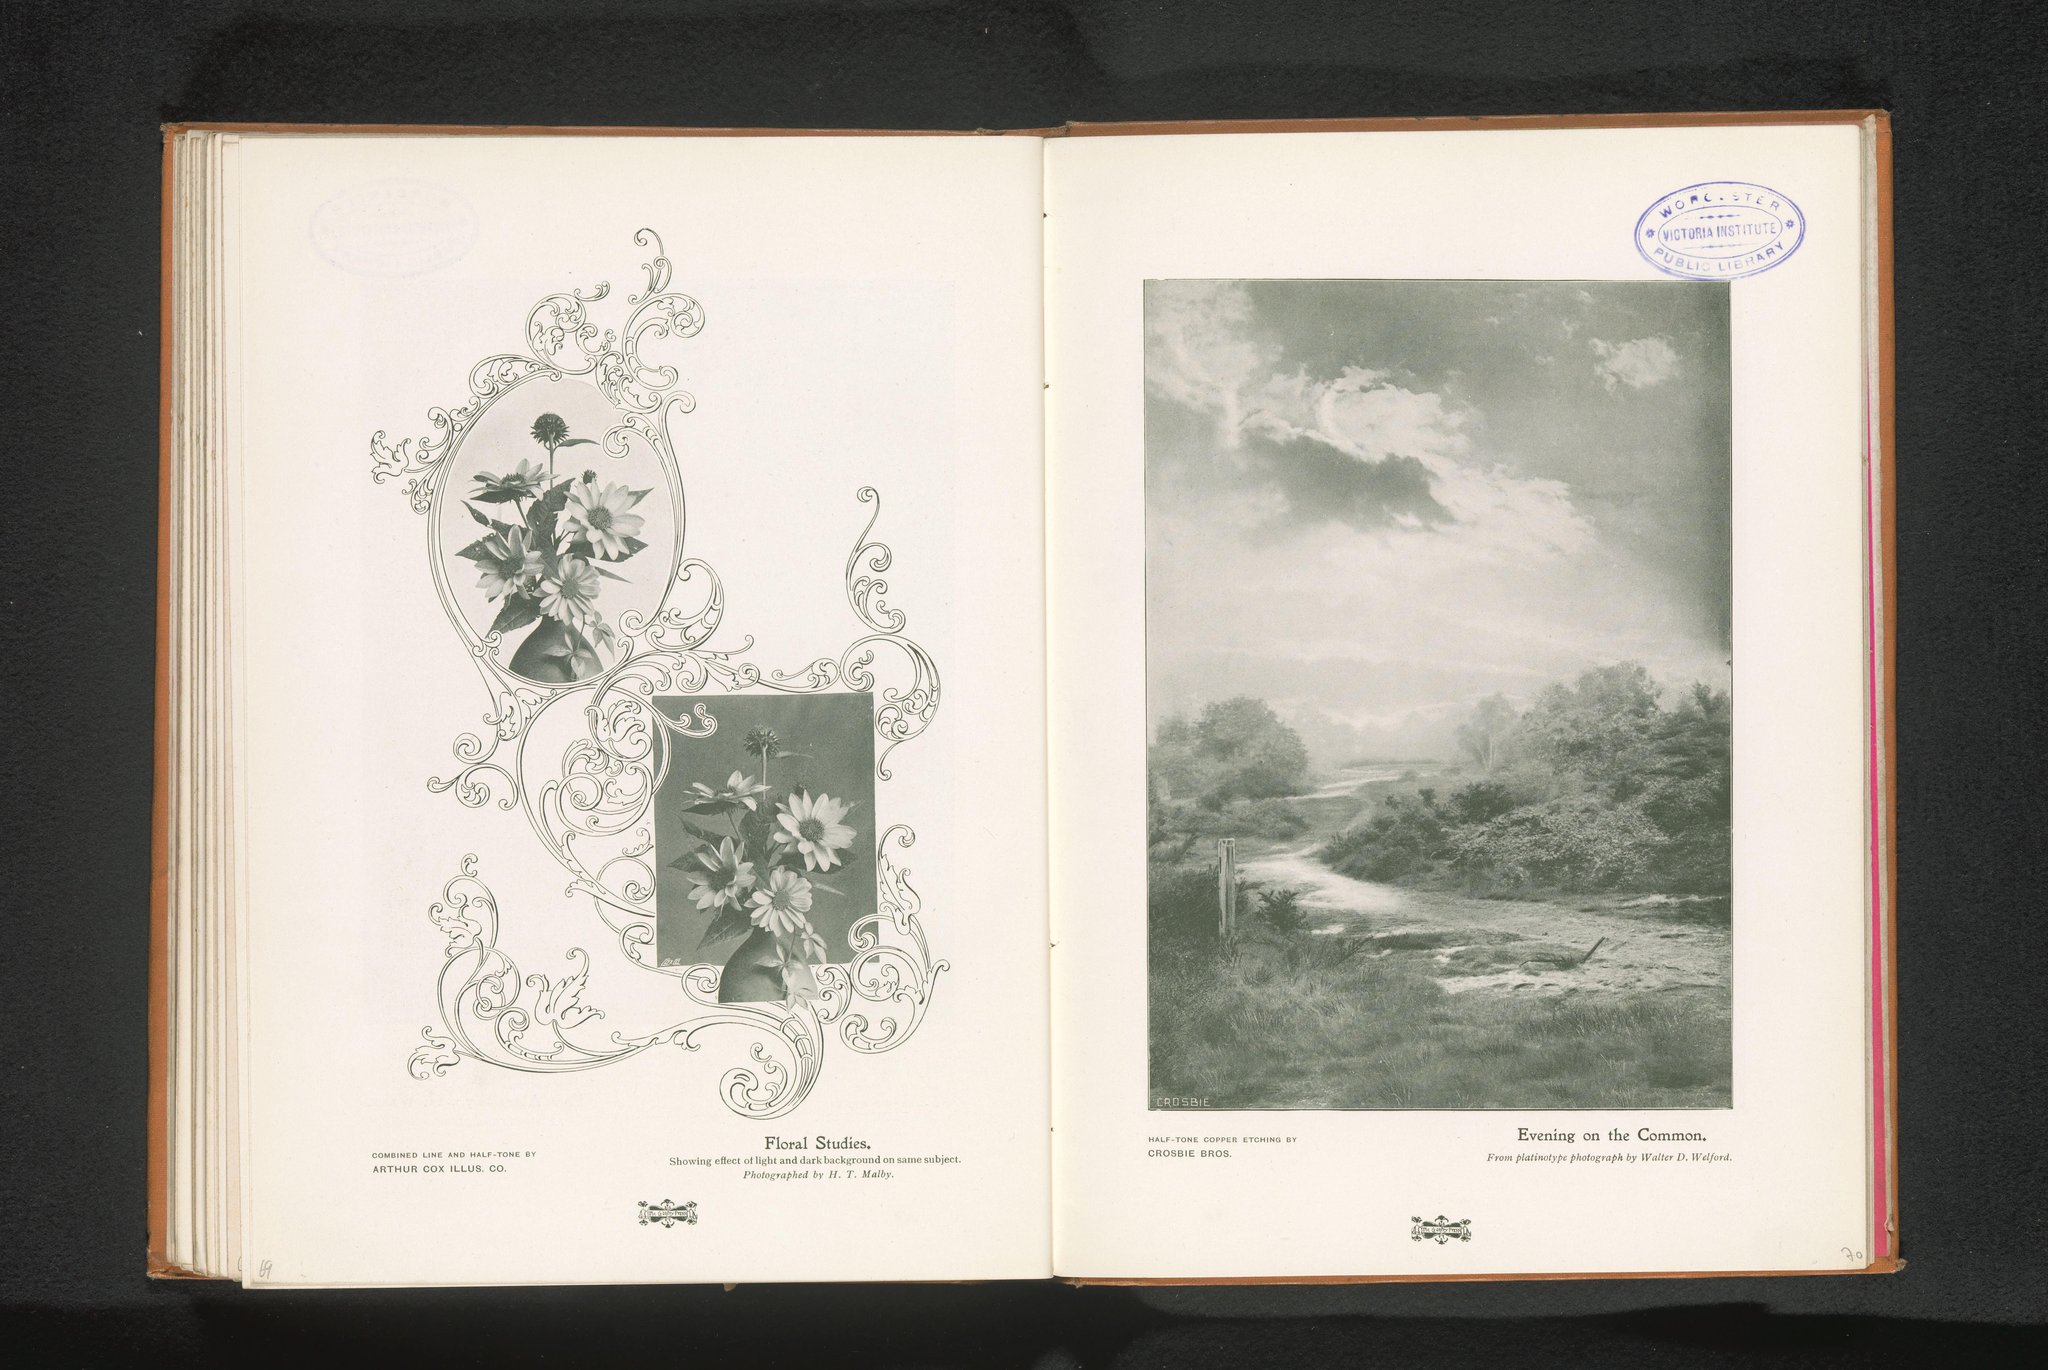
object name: photomechanical print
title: Floral studies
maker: henry thomas malby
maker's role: fotograaf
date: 1894-1899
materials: paper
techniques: autotype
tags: flowers in a vase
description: Prent op tweede ongenummerde pagina na pagina 96.